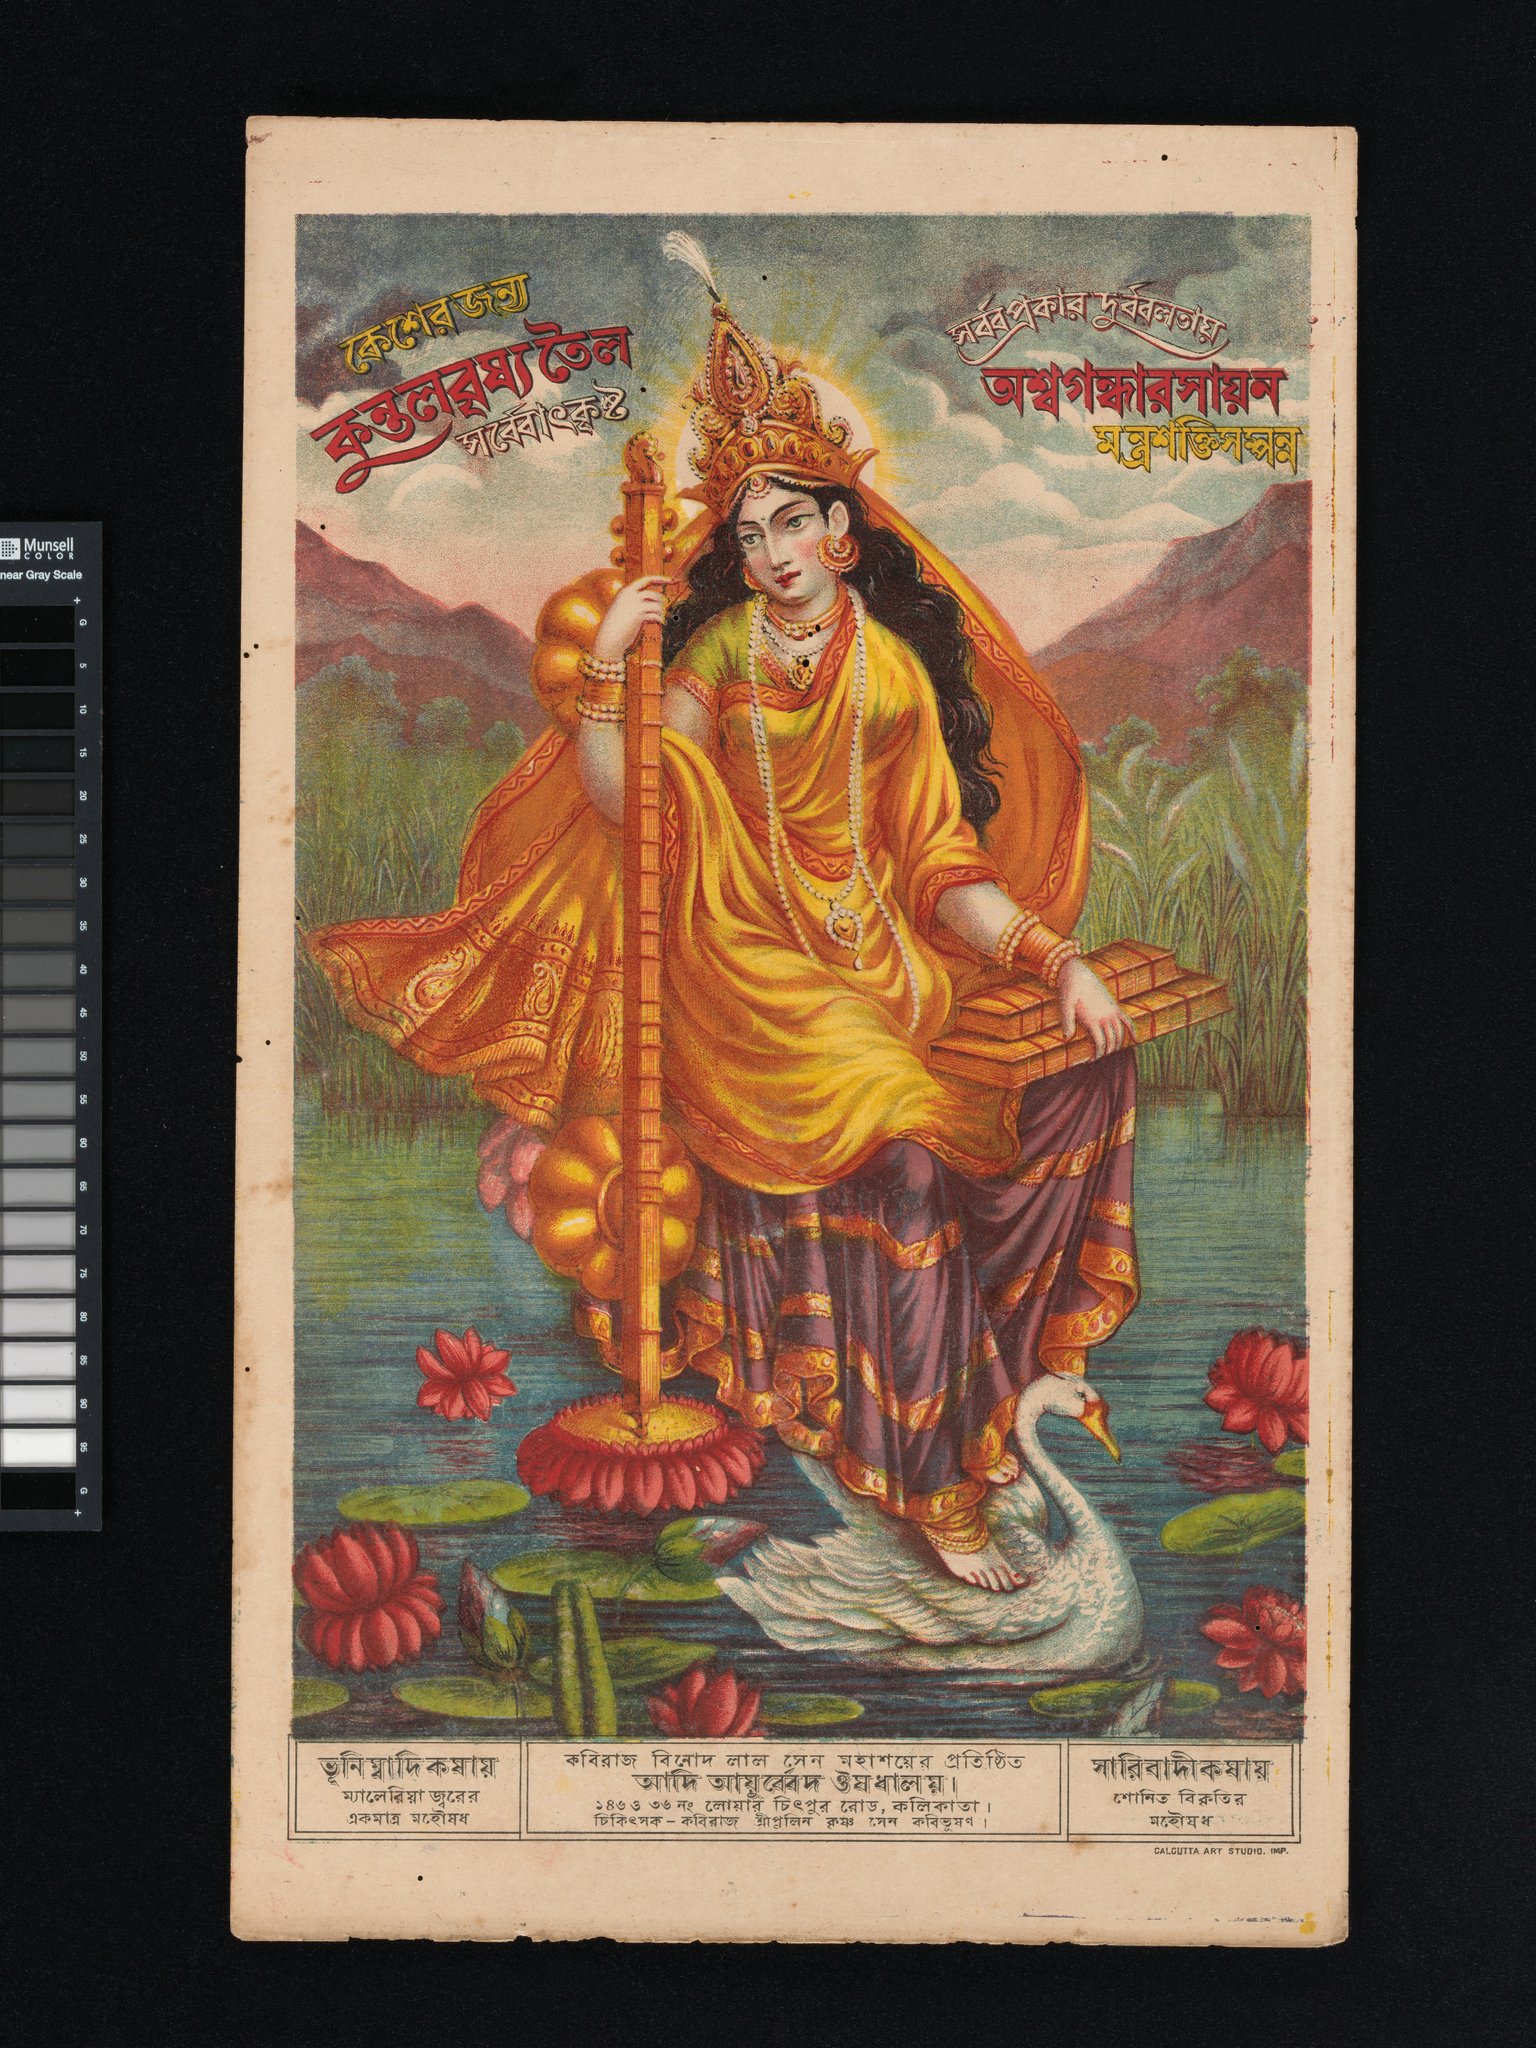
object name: lithograph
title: Sarasvati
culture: indian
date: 1885-1895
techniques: lithograph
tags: goddess,hinduism